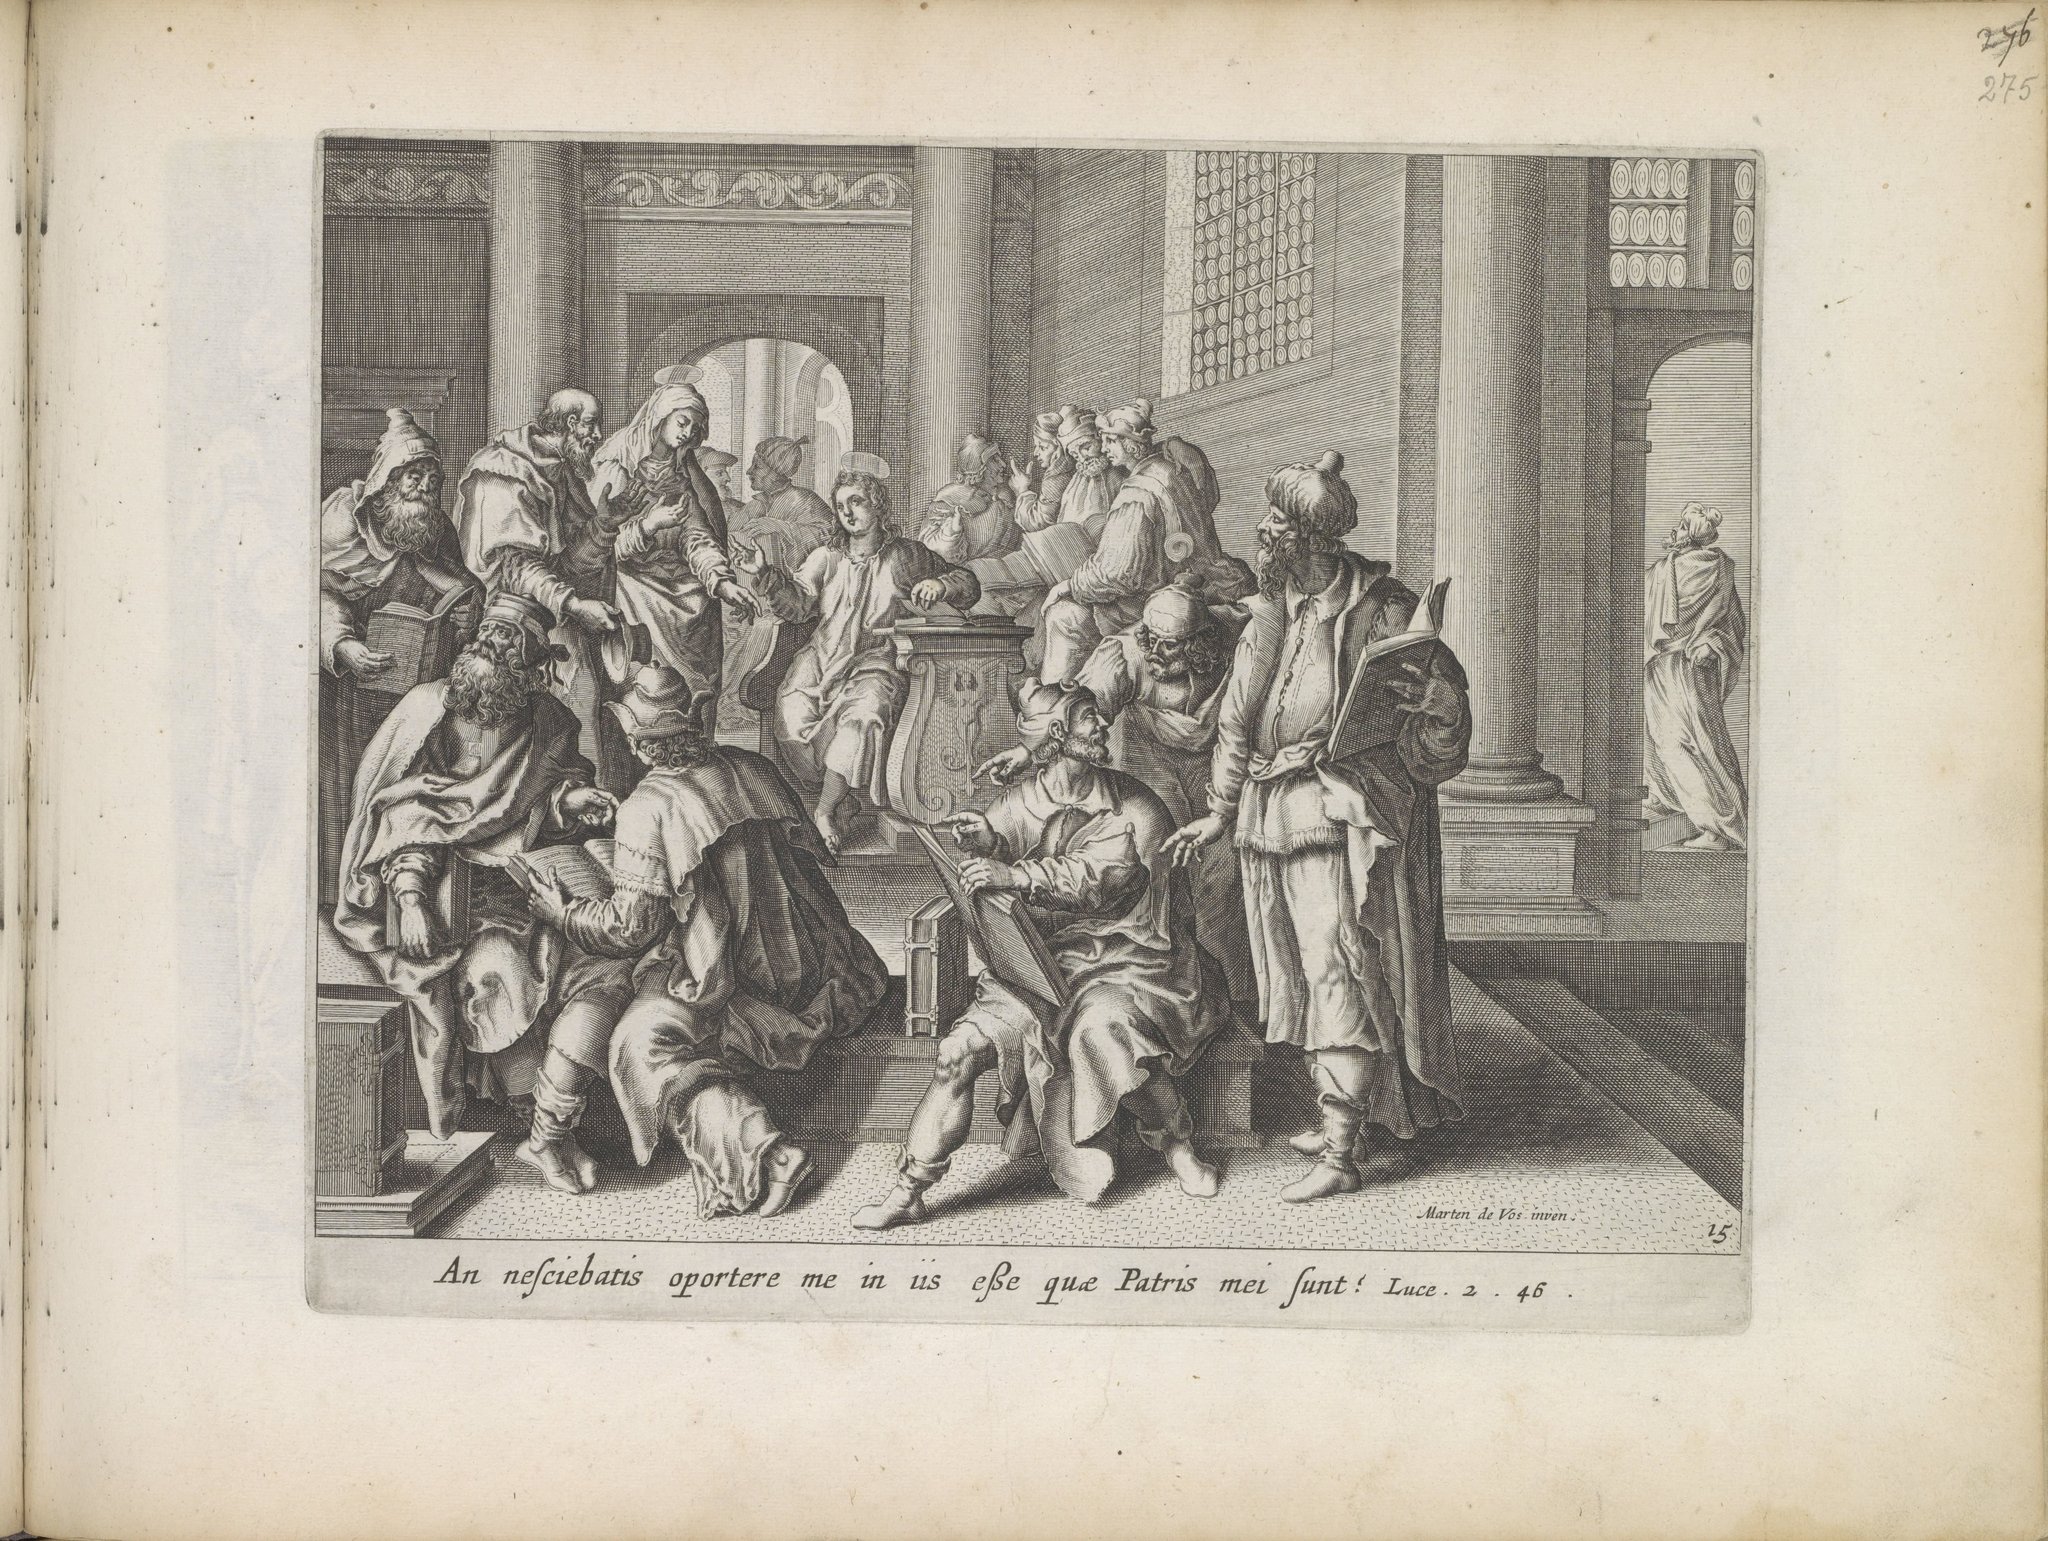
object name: album leaf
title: Jeugd van Christus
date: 1643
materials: paper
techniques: engraving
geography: amsterdam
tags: christ's dispute with the doctors in the temple; he counts his arguments on his fingers, christ found by his parents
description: Christus zit tussen de schriftgeleerden en legt hen de schrift uit. Christus maakt een spreekgebaar. Links van hem staan Jozef en Maria. Onder de voorstelling een verwijzing in het Latijn naar de Bijbeltekst in Mat. 2:46. Deze prent maakt deel uit van een album.